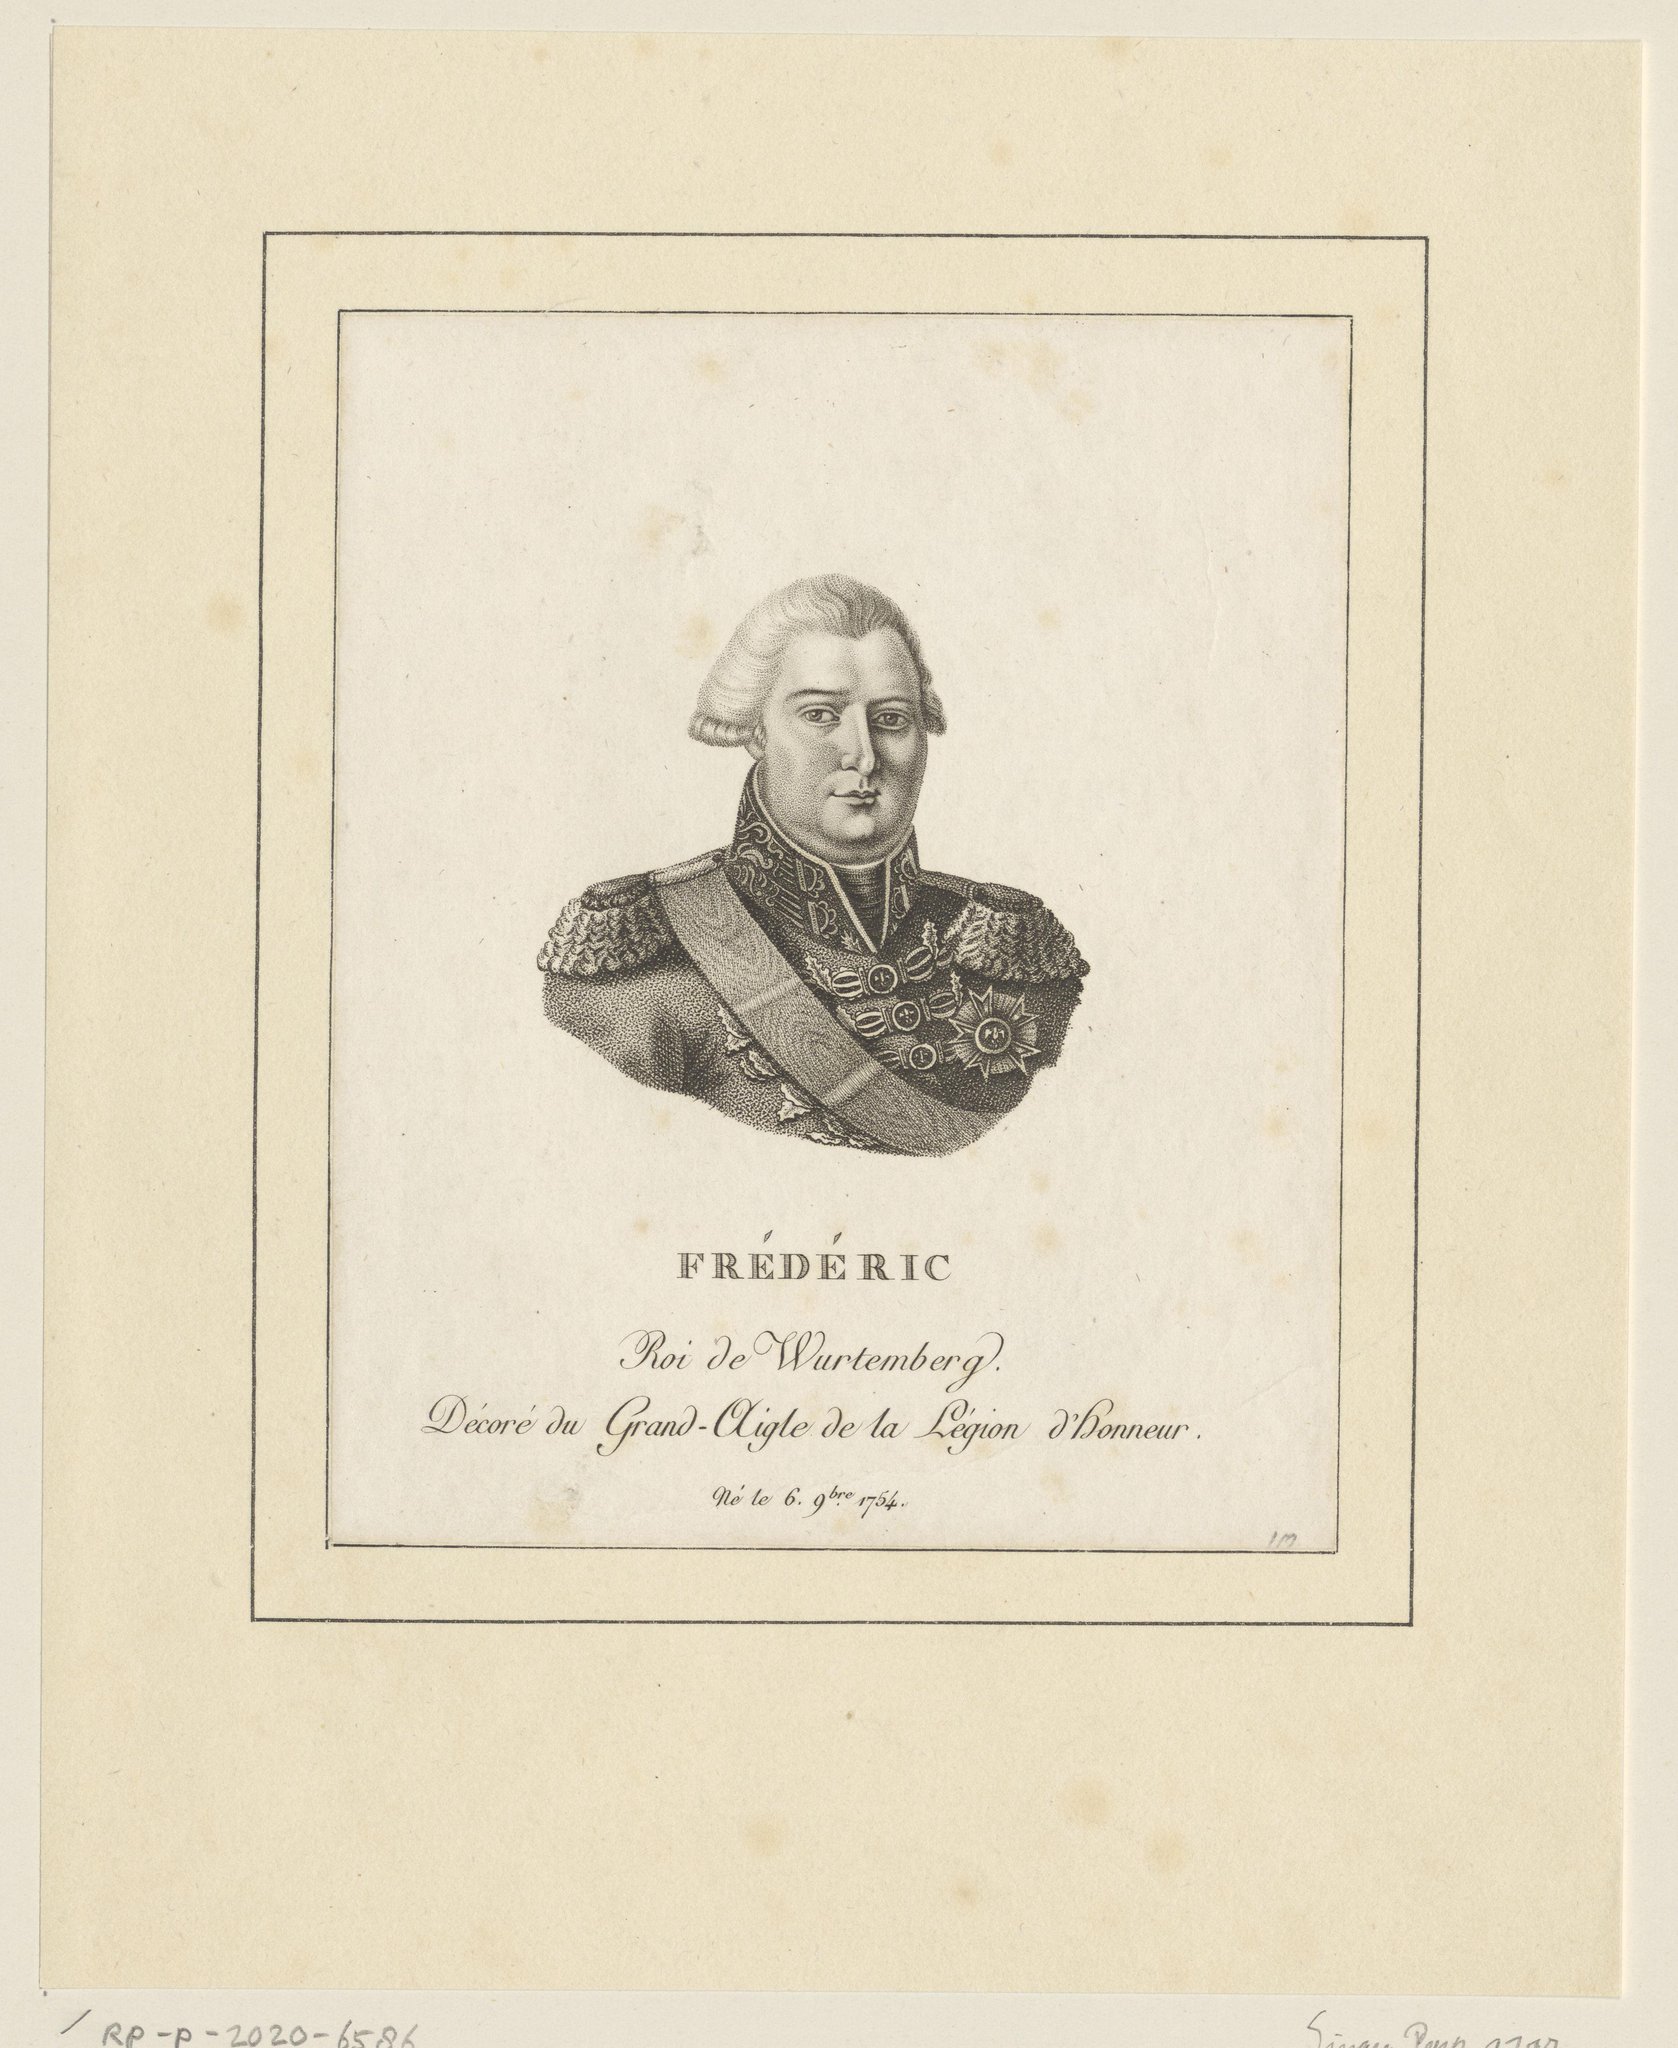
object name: print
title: Portretten van leden van het Legioen van Eer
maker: Anonymous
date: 1810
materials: paper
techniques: engraving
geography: france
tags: historical persons, king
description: Prent waarschijnlijk uit: Collection complète des portraits des Grands-Aigles et des Grands-Officiers de la Légion d'Honneur (...). Parijs: M. Meyer, 1810.